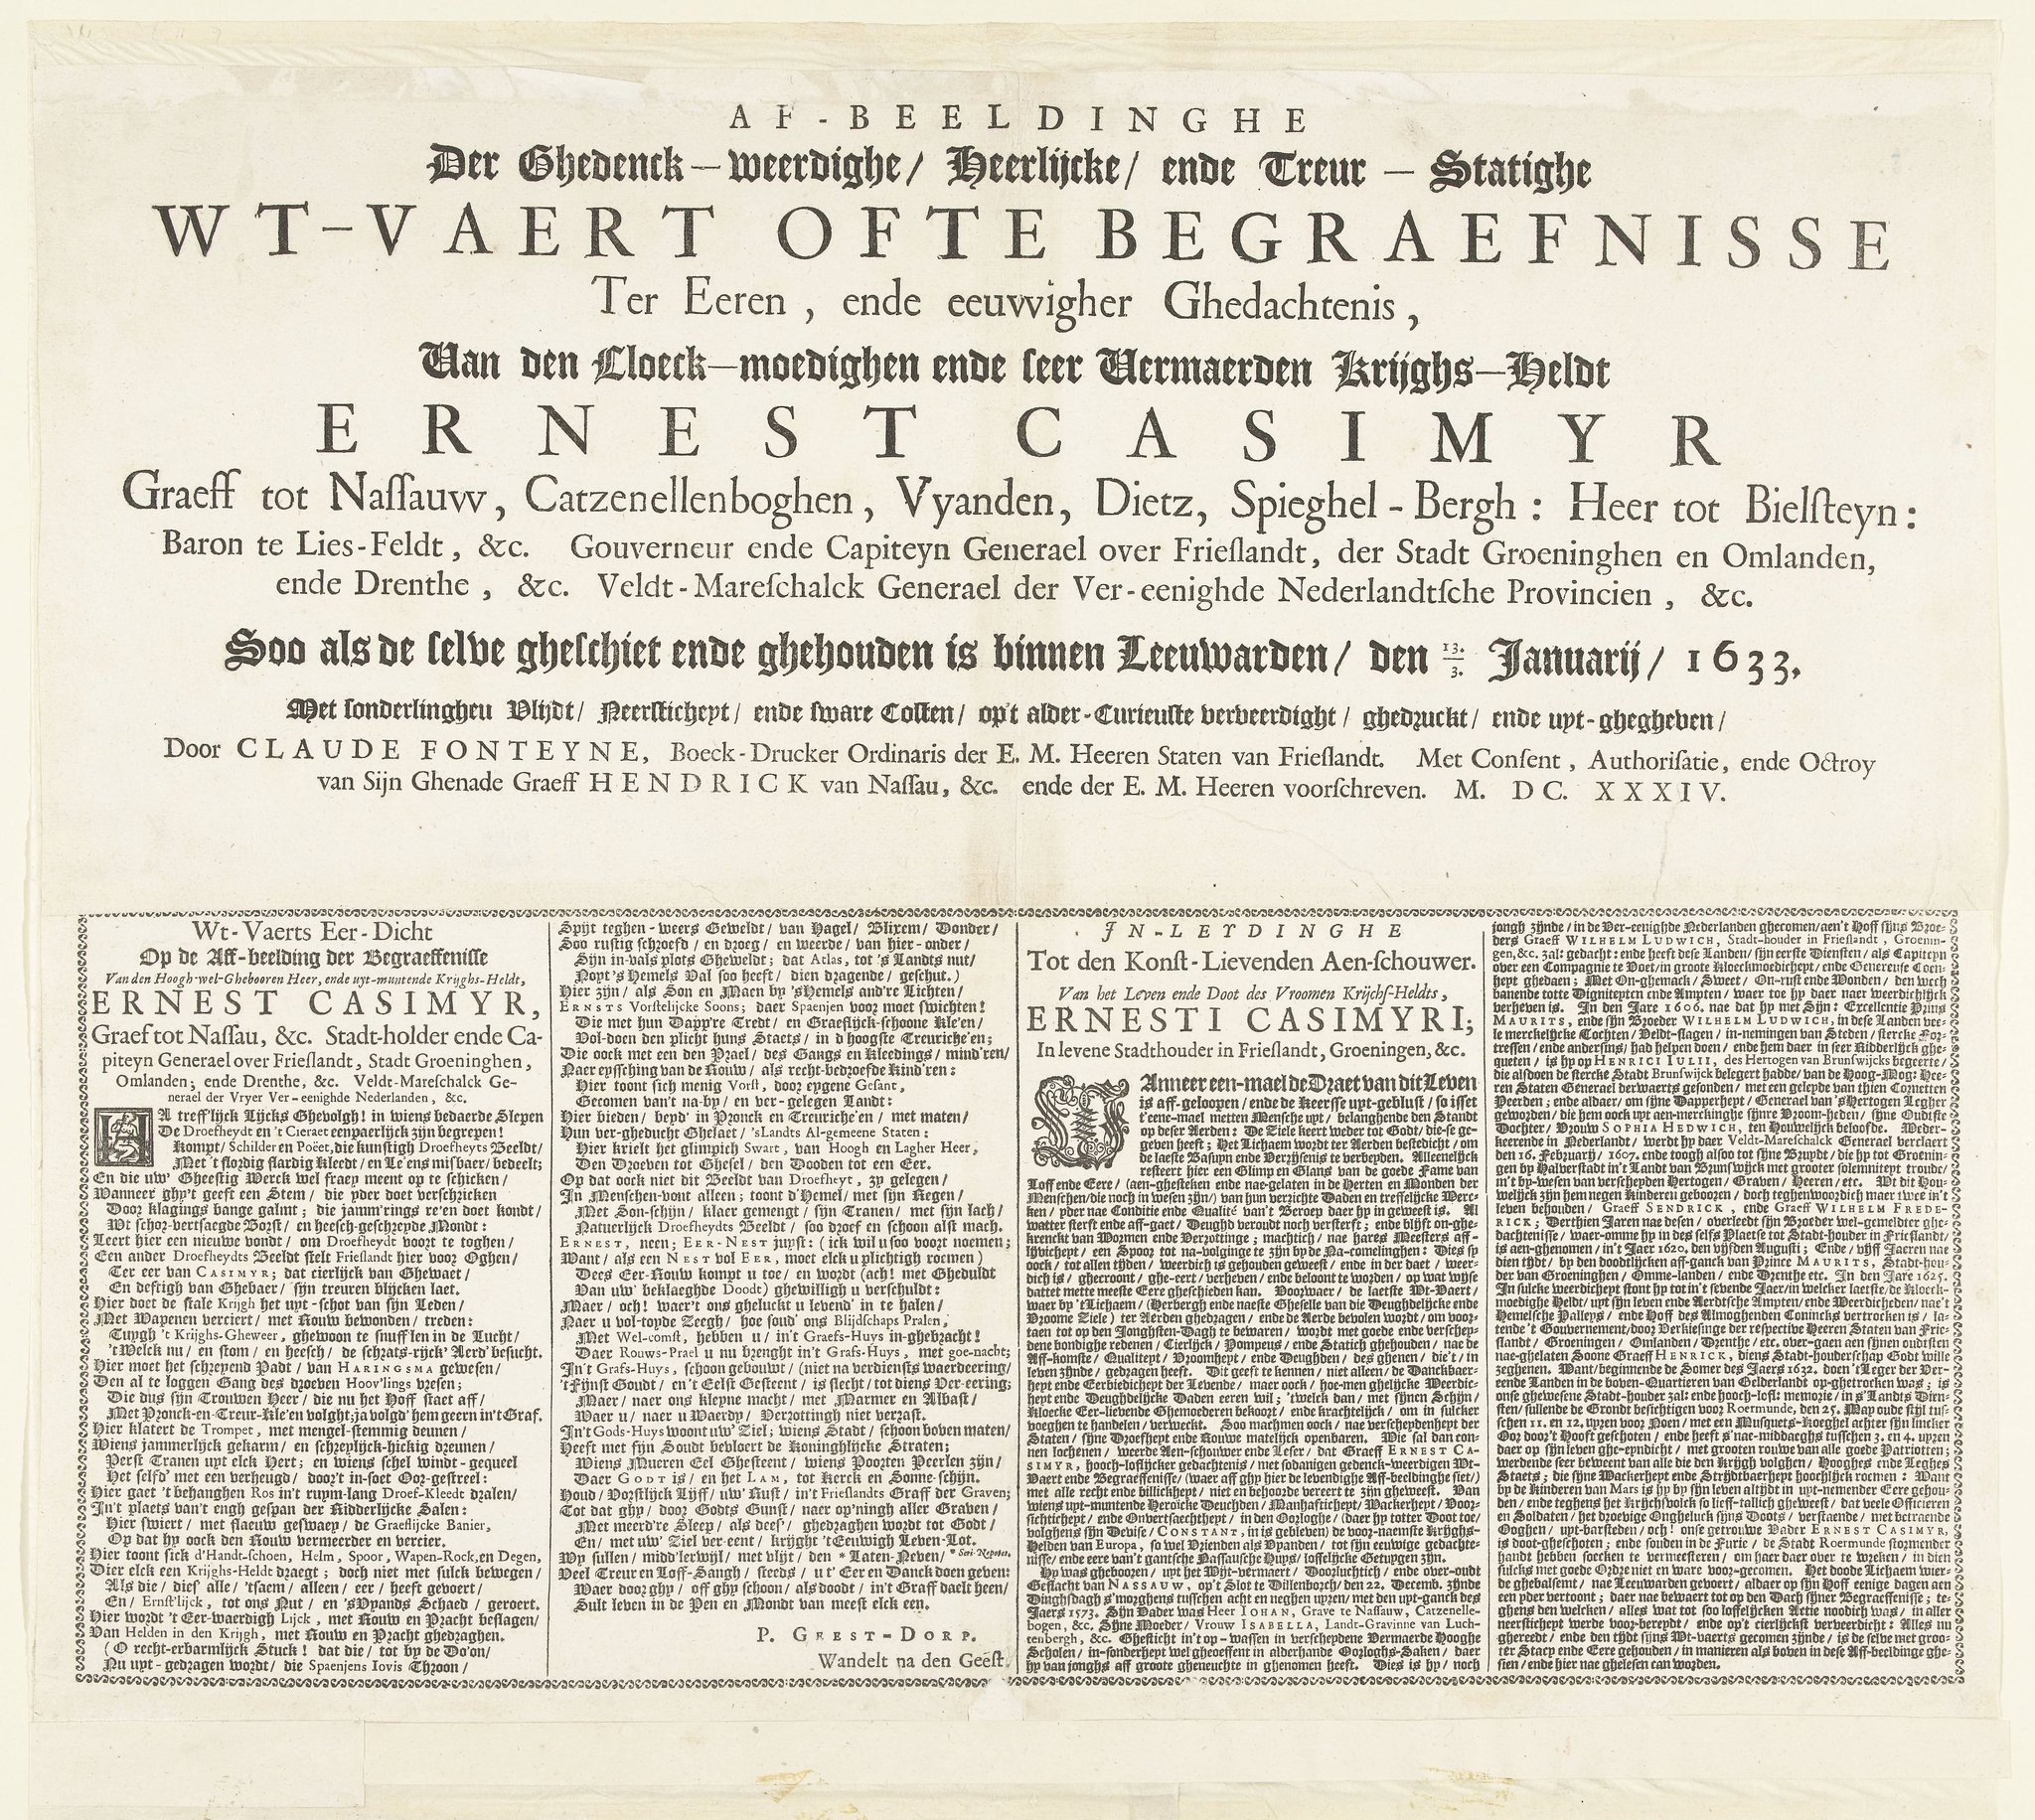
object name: text sheet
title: Afbeeldinghe Der Ghedenck-weerdighe / Heerlijcke / ende Treur-Statighe Wt-Vaert ofte Begraefnisse Ter Eeren, ende eeuwigher Ghedachtenis, Van den Cloeck-moedighen ende seer Vermaerden Krijghs-Heldt Ernst Casimyr Graeff tot Nassauw, Catzenellenboghen (...) Soo als de selve gheschiet ende ghehouden is binnen Leeuwarden / den 13./3. Januarij / 1633.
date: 1634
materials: paper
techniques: letterpress printing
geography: leeuwarden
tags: ernst casimir graaf van nassau-dietz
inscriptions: date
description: Tekstblad met de titel, een gedicht en de inleiding voor de prentserie van de begrafenis van Ernst Casimir, graaf van Nassau-Dietz te Leeuwarden, 3 januari 1633. Twee bladen en enkele losse strookjes papier aan elkaar geplakt, boven de titel, onder in 3 kolommen het gedicht en de inleiding. Bestemd om afzonderlijk onder de prenten geplakt te worden.